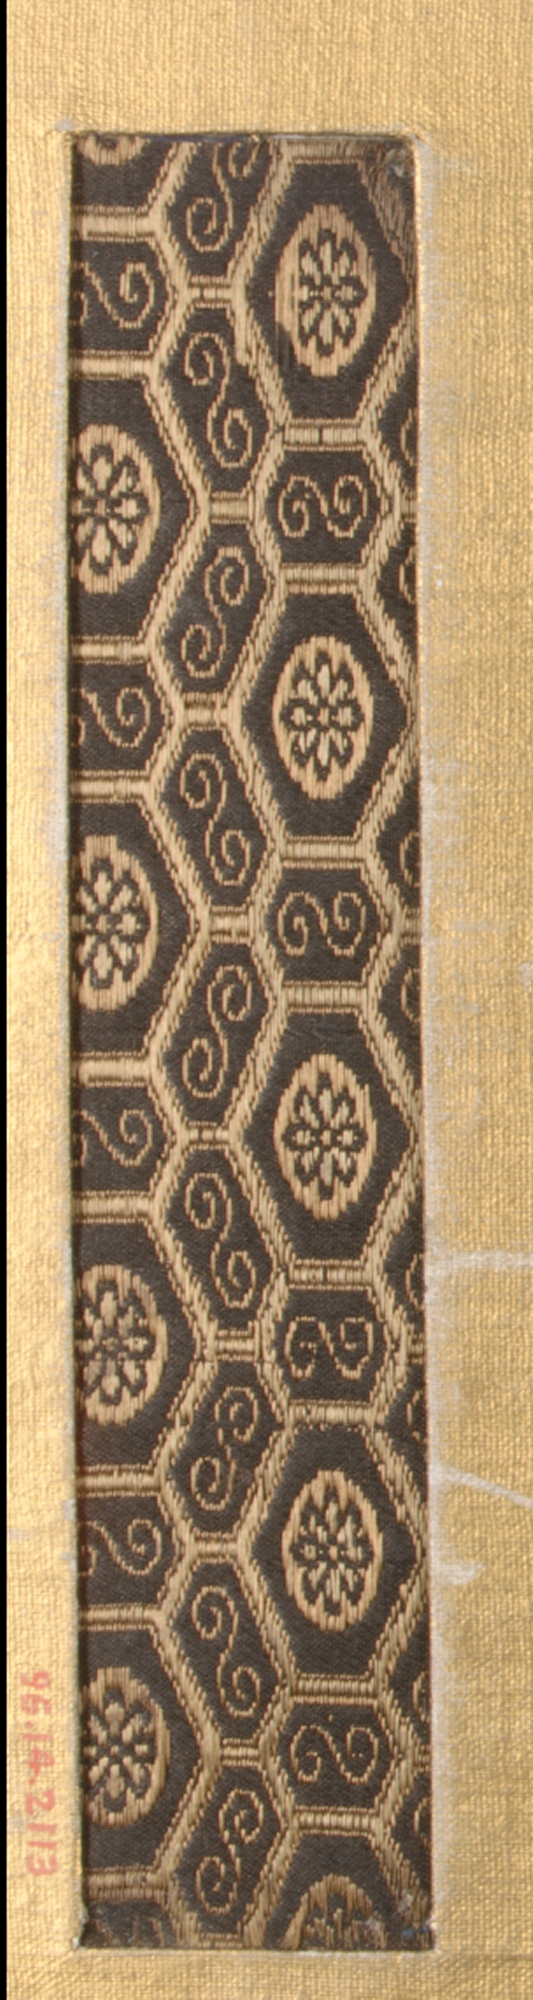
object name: piece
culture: japanese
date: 1701-1900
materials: silk